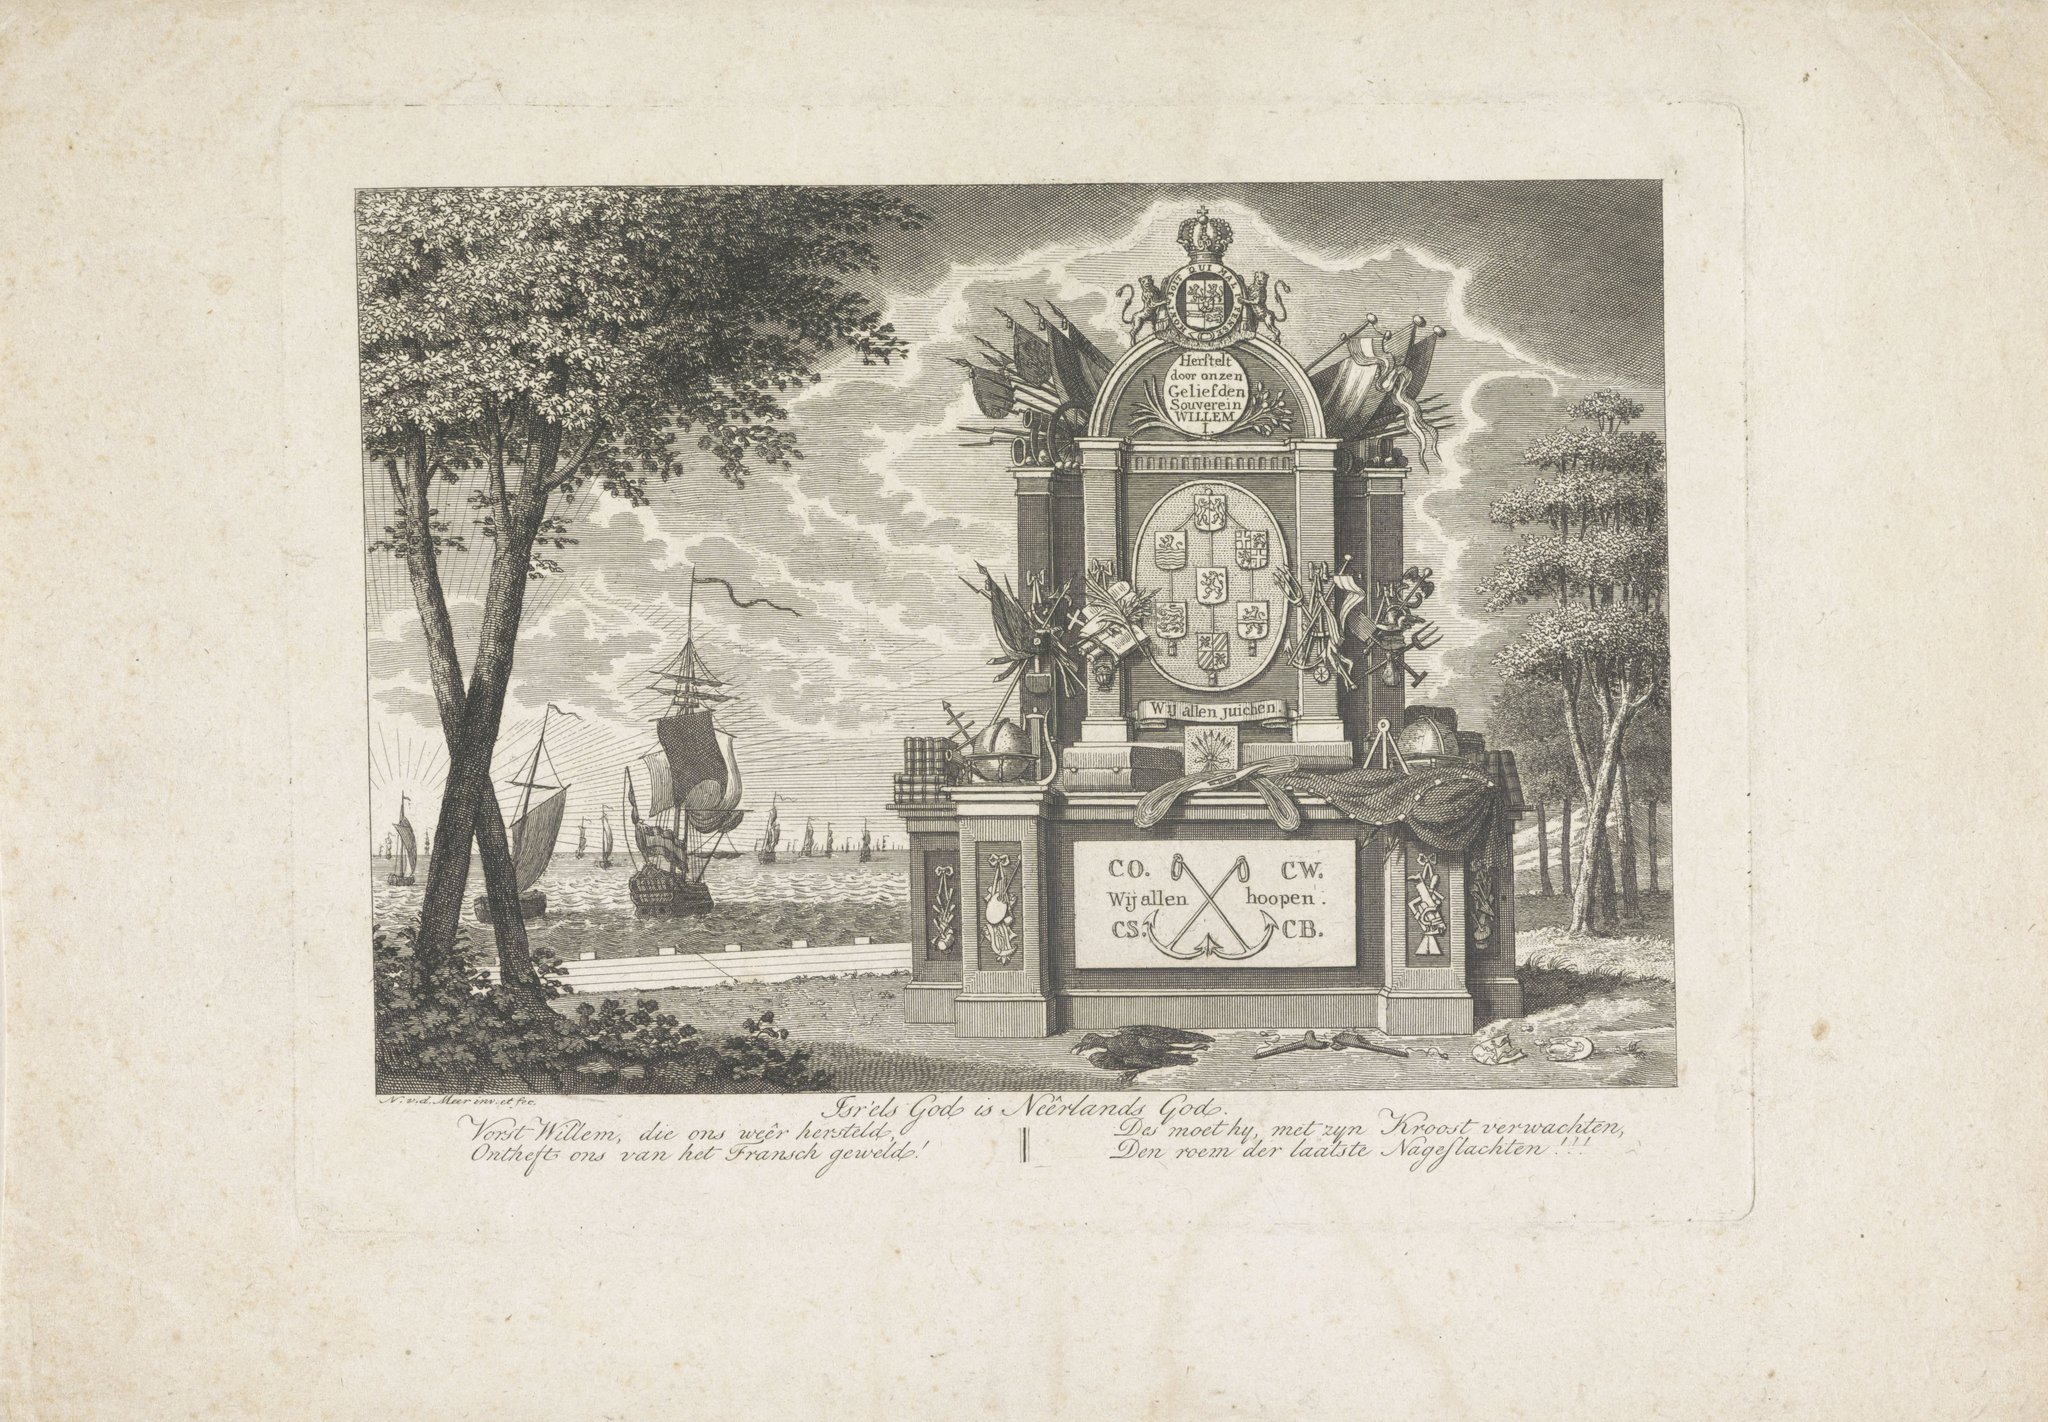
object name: print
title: Allegorie op de bevrijding van Nederland, 1813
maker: noach van der meer (ii)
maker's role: draughtsman, print maker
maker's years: 1741-1822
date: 1813-1814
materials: paper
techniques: engraving, etching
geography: netherlands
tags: berlin, william i of the netherlands, landscape with monument, sunrise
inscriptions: collector's mark: Lugt 2228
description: Allegorie op de bevrijding van Nederland, de val van de Fransen en het herstel van de prins van Oranje als soeverein vorst, 1813. Kustlandschap met monument voor de zeven verenigde provincies bekroond door het wapen van de prins. Op de grond voor het monument liggen symbolen van de gebroken Franse macht. Op het monument een cartouche met twee gekruiste ankers en de monogrammen CO, CW, CB en CS en de spreuk 'Wij allen hoopen'. Links rijst de zon over een handelsvloot op zee. In het onderschrift een vierregelig vers. Zie de pendant.